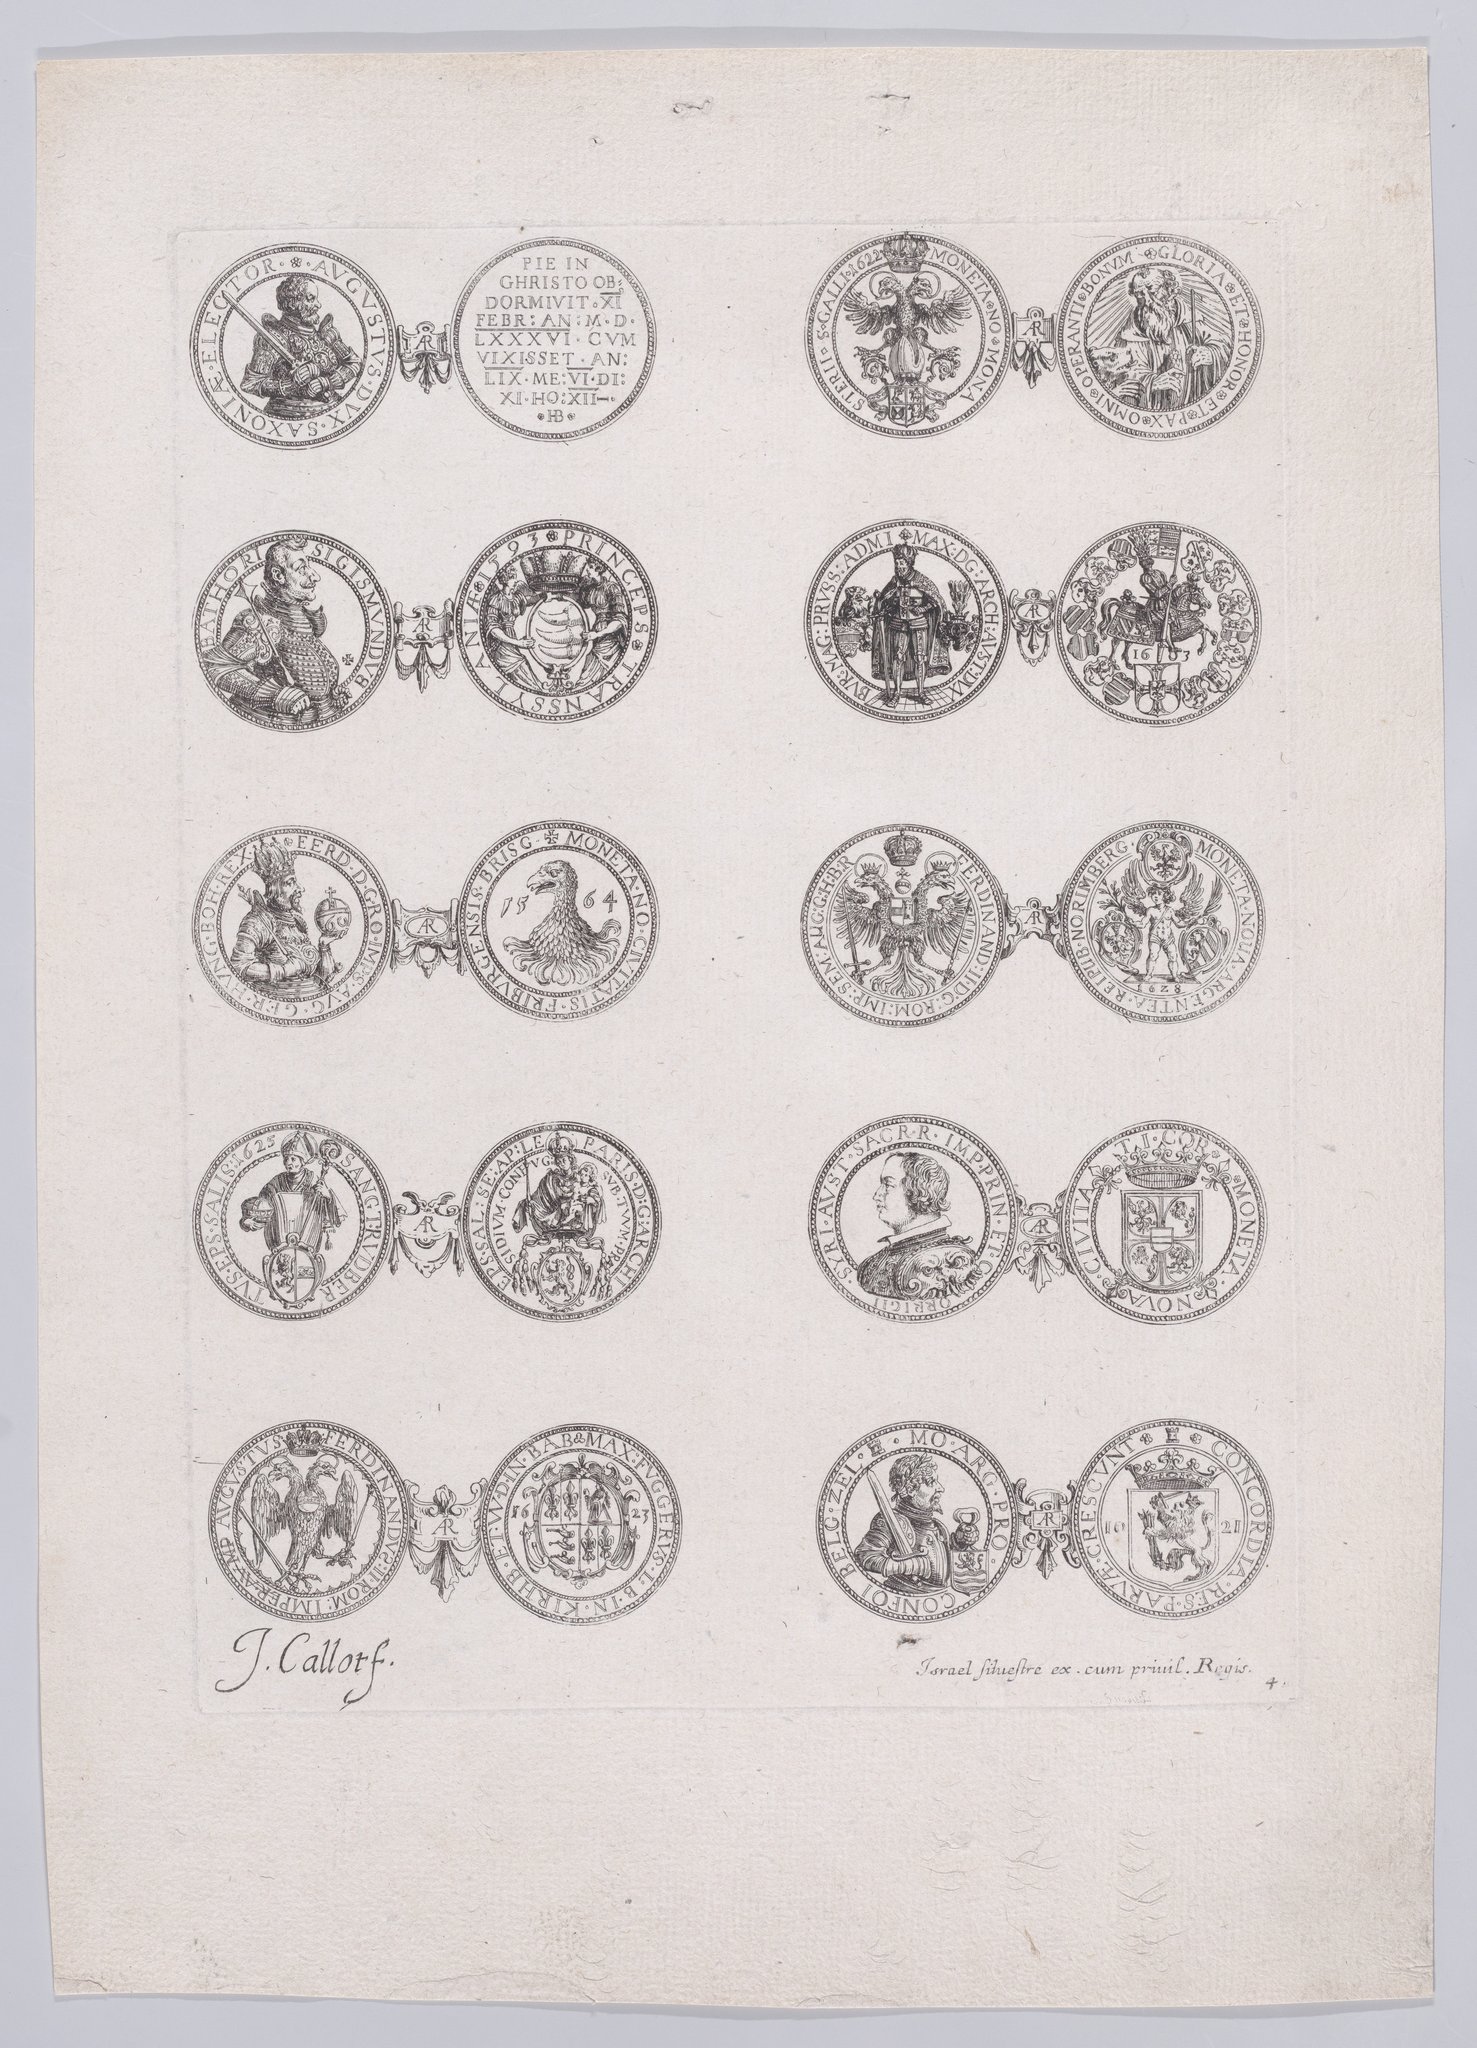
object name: print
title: 4th Plate, Featuring 10 Coins Issued by European Princes in the 16th and 17th centuries, from Les Monnaies (The Currencies)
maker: jacques callot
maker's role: artist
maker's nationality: french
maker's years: 1592-1635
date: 1630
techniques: etching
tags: coins